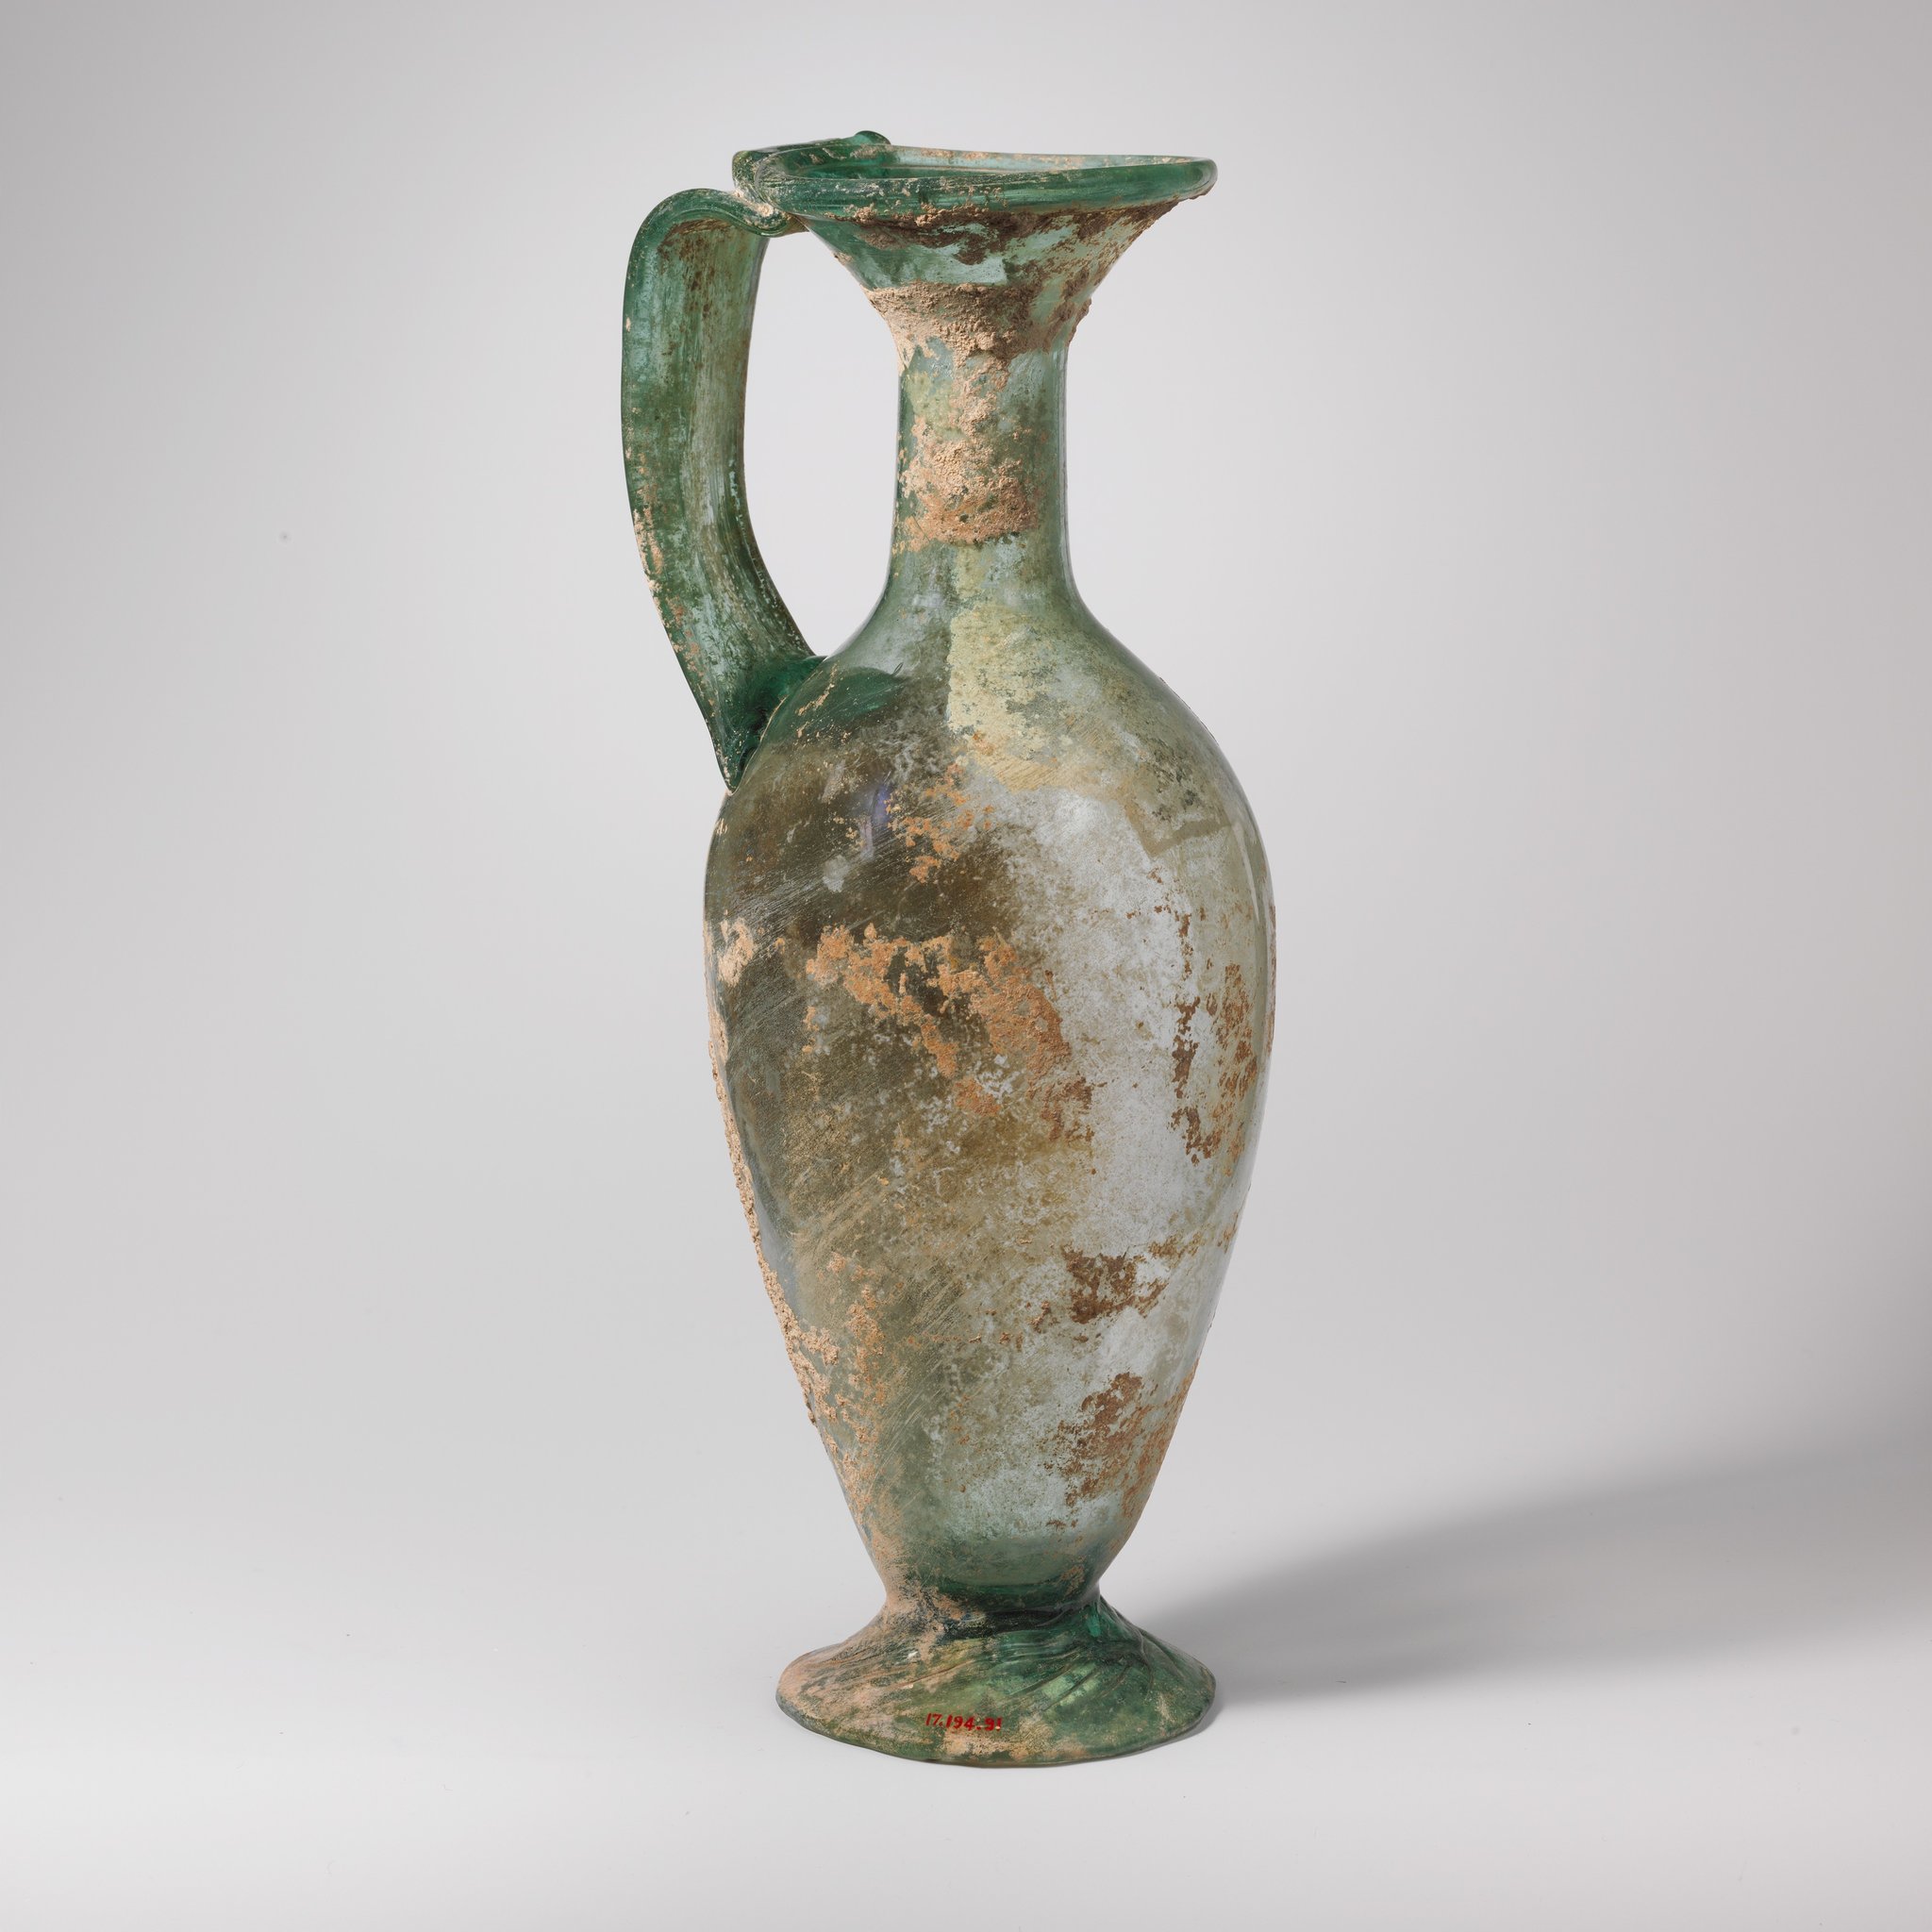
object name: jug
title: Glass jug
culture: roman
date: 301-400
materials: glass